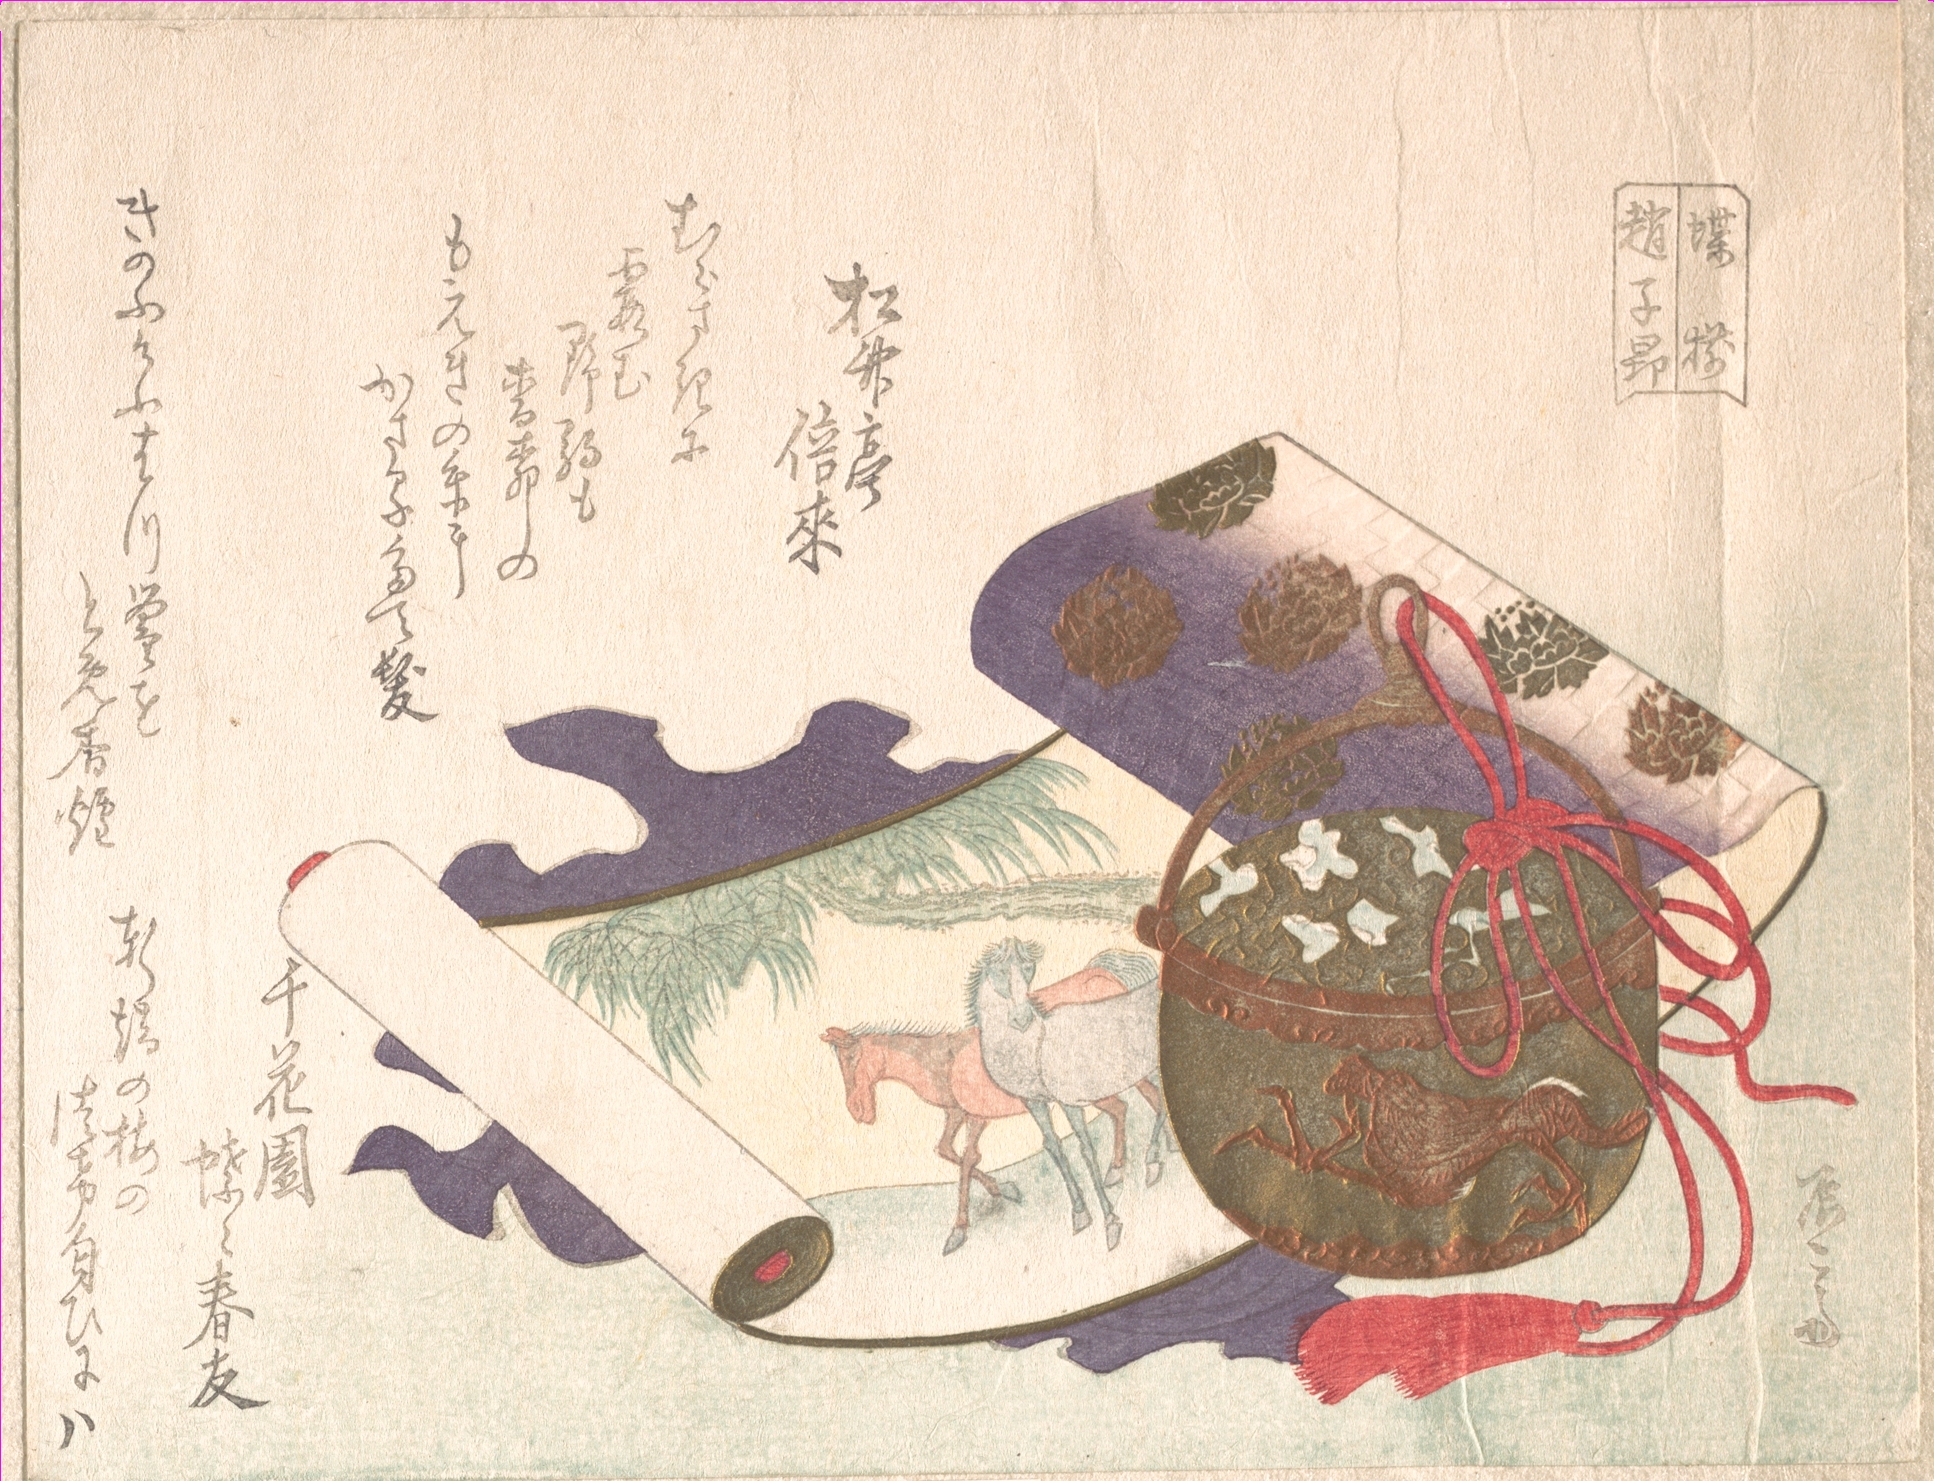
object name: woodblock print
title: Scroll Painting of Horse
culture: japanese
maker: ryūryūkyo shinsai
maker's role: artist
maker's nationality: japanese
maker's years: 1799-1823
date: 1801-1900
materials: ink, paper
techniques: surimono, woodblock print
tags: scrolls,horses